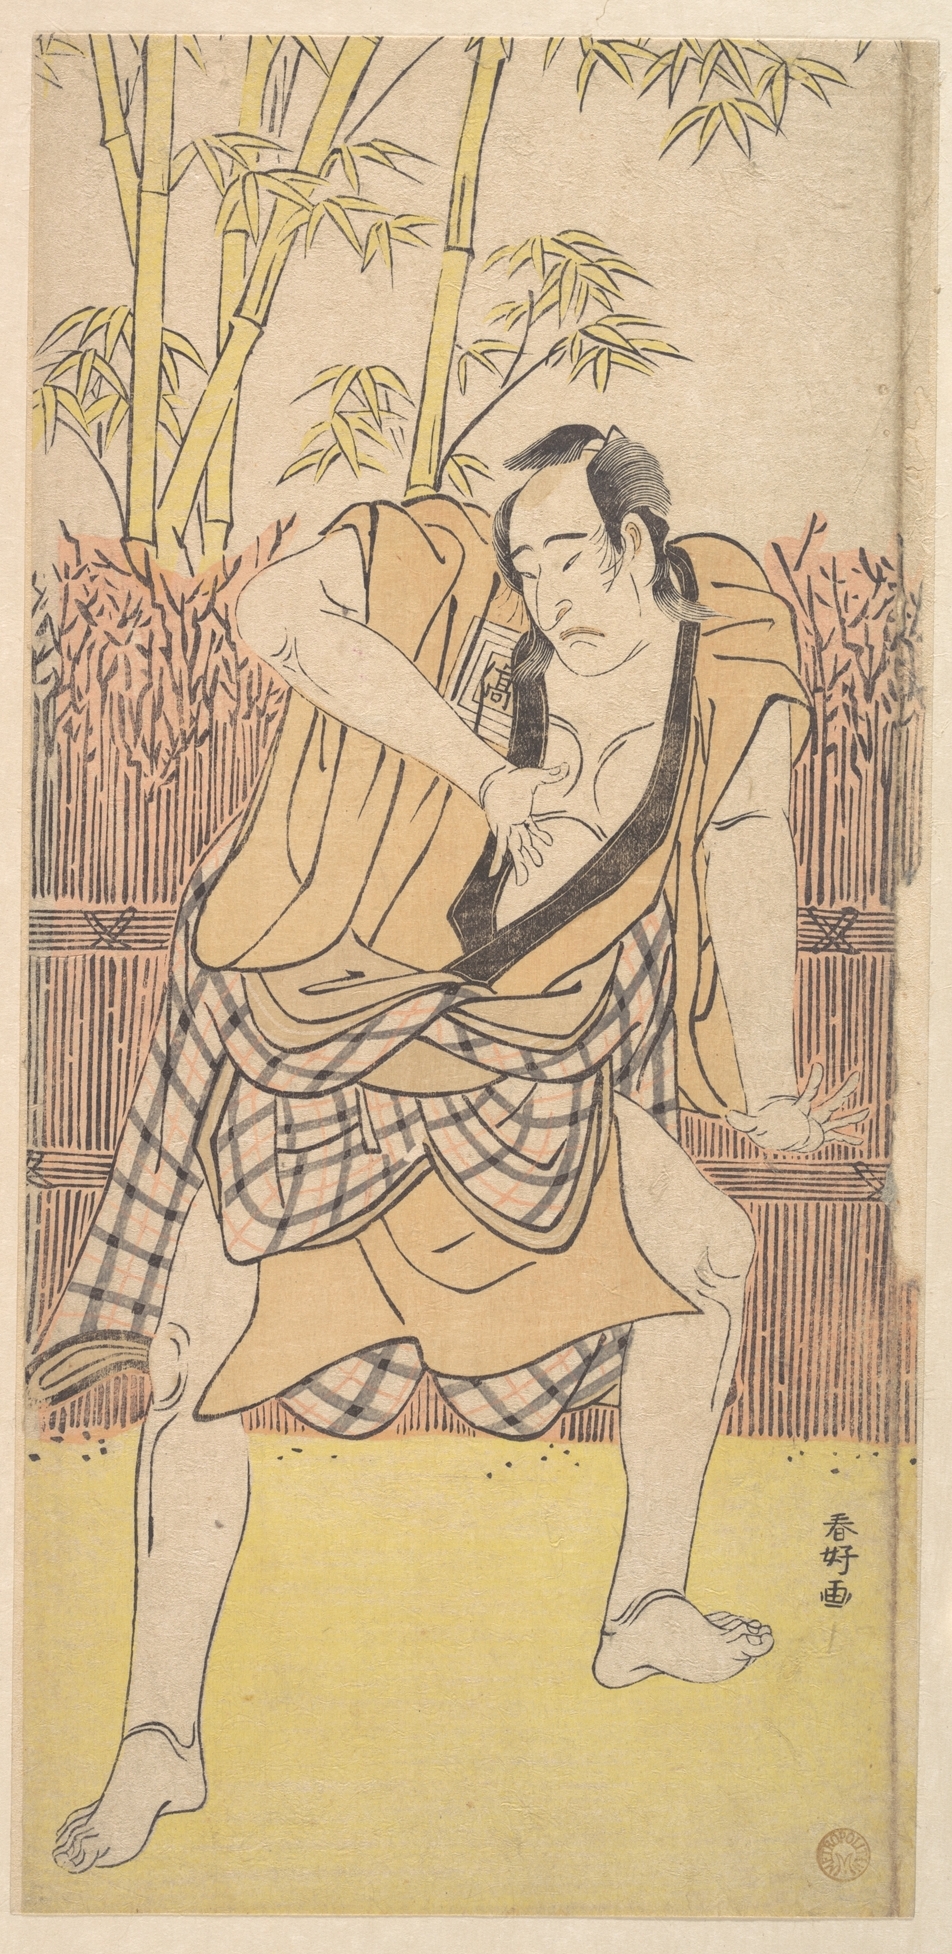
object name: woodblock print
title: The Second Ichikawa Komazo as a Man standing in a Dramatic Attitude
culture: japanese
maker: katsukawa shunkō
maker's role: artist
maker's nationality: japanese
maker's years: 1743-1812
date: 1790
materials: ink, paper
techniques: woodblock print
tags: men,bamboo,actors